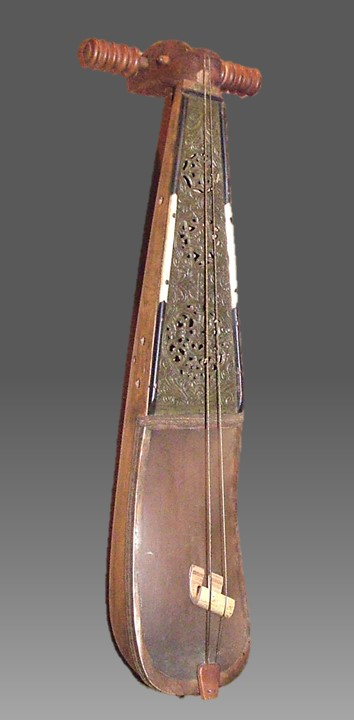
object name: rebab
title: Rebāb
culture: algerian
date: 1801-1900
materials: bone, brass, lace, leather, mother of pearl, wood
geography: algeria